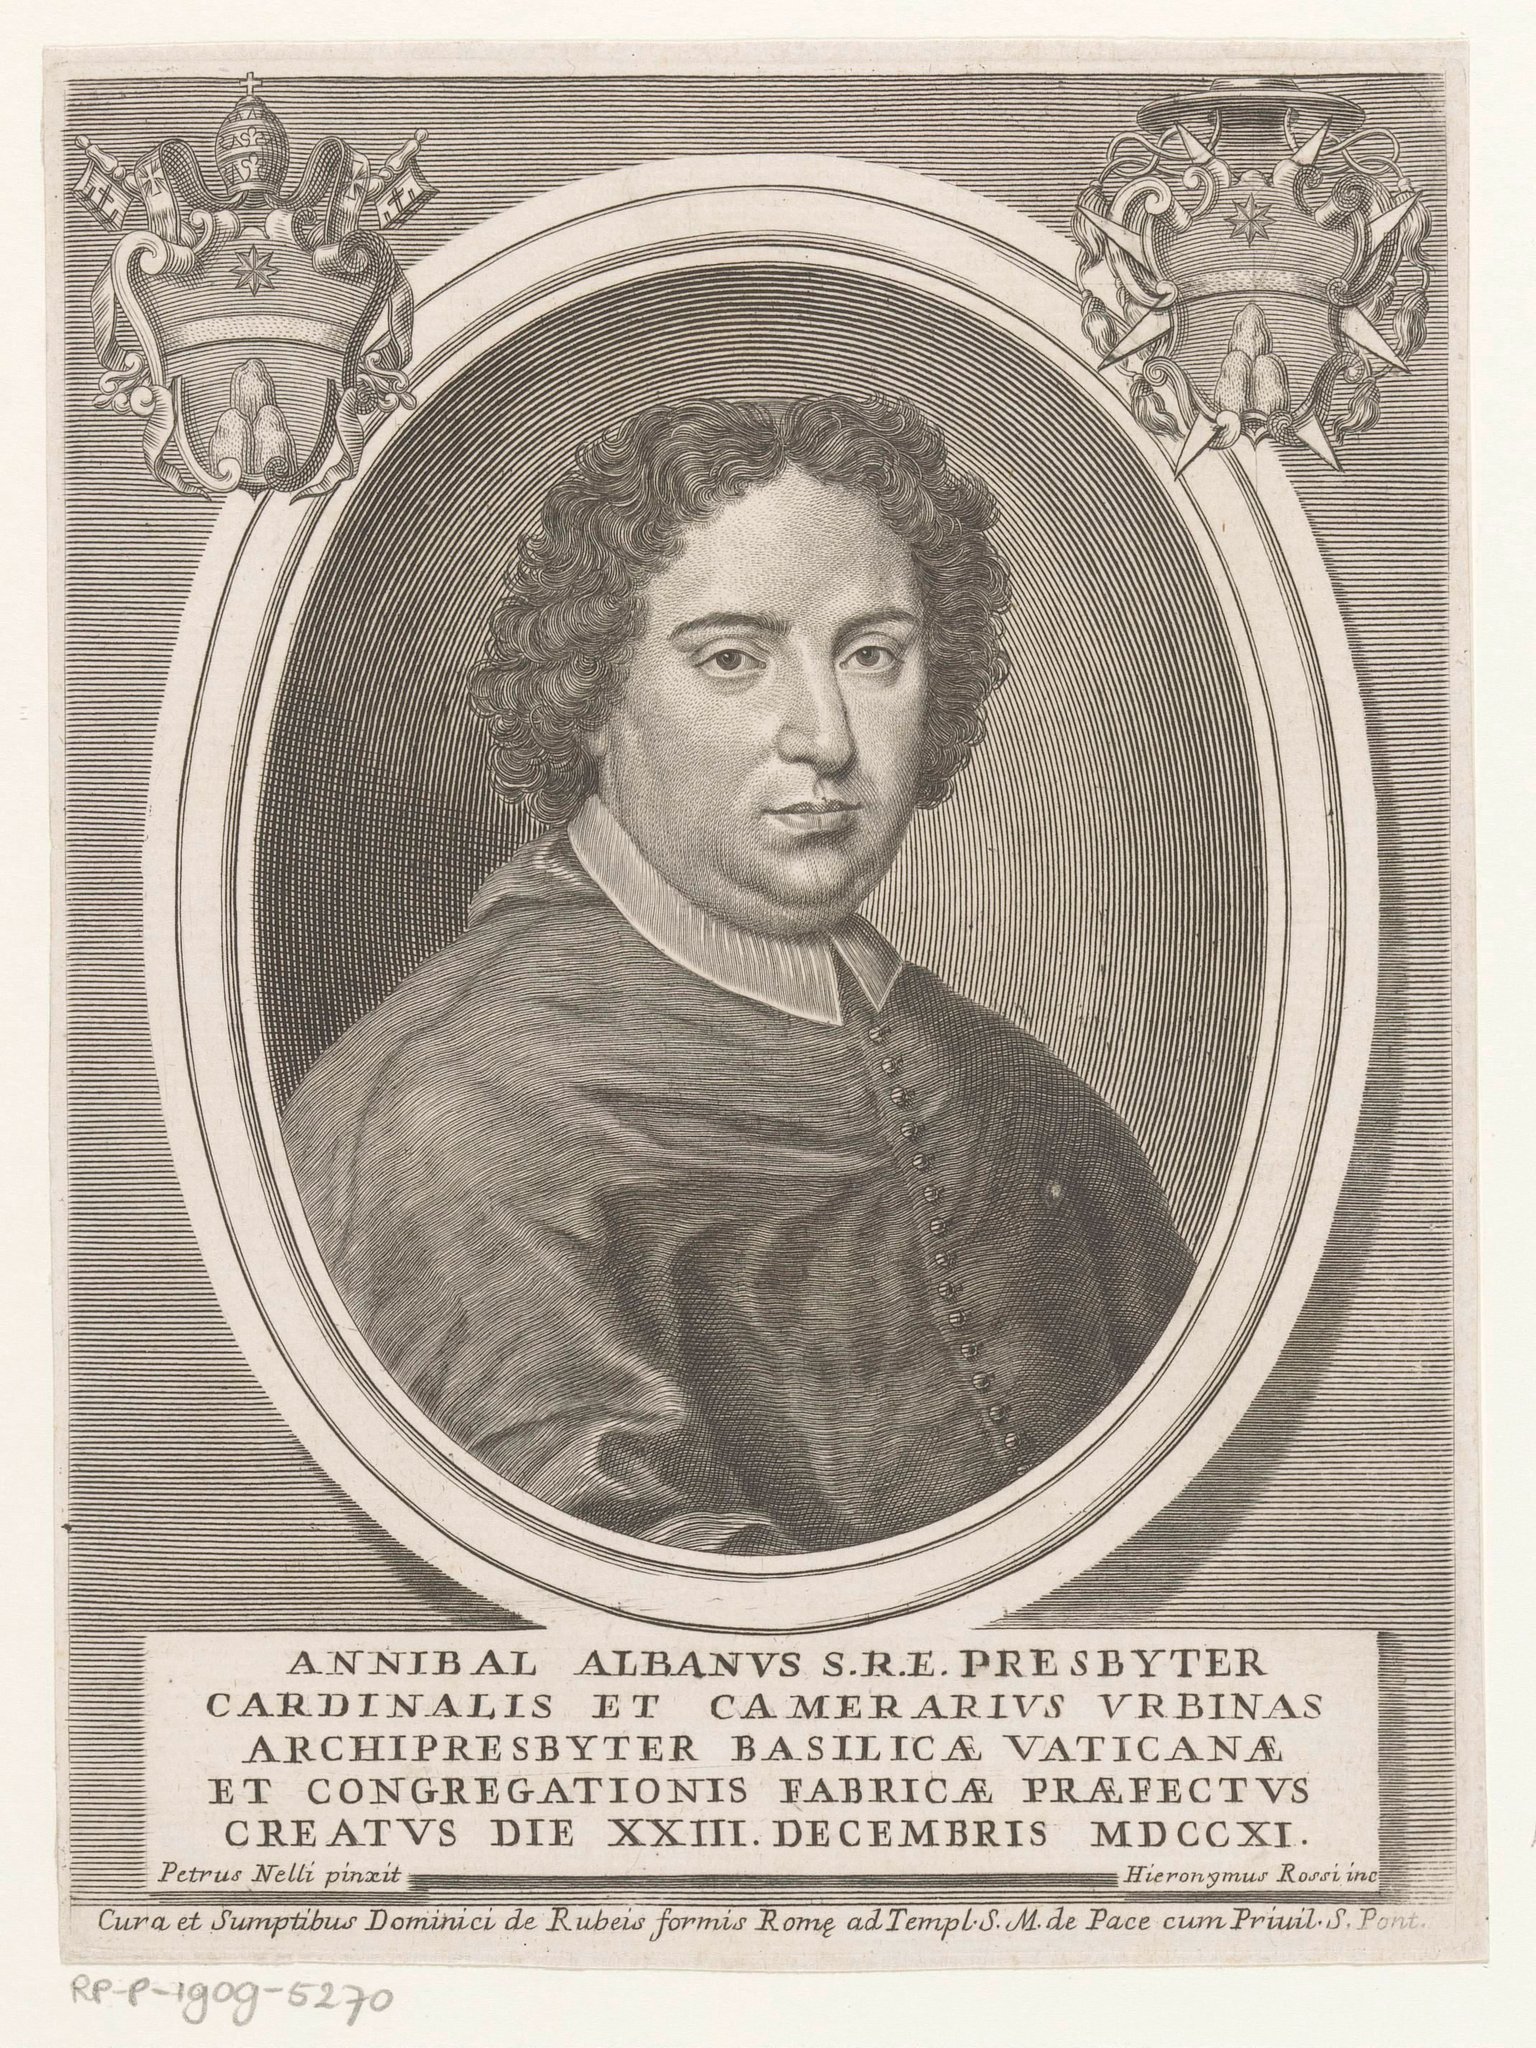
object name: print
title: Portret van kardinaal Annibale Albani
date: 1711-1762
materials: paper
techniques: engraving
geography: italy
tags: rome, annibale albani, cardinal, historical persons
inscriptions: collector's mark: Lugt 2228